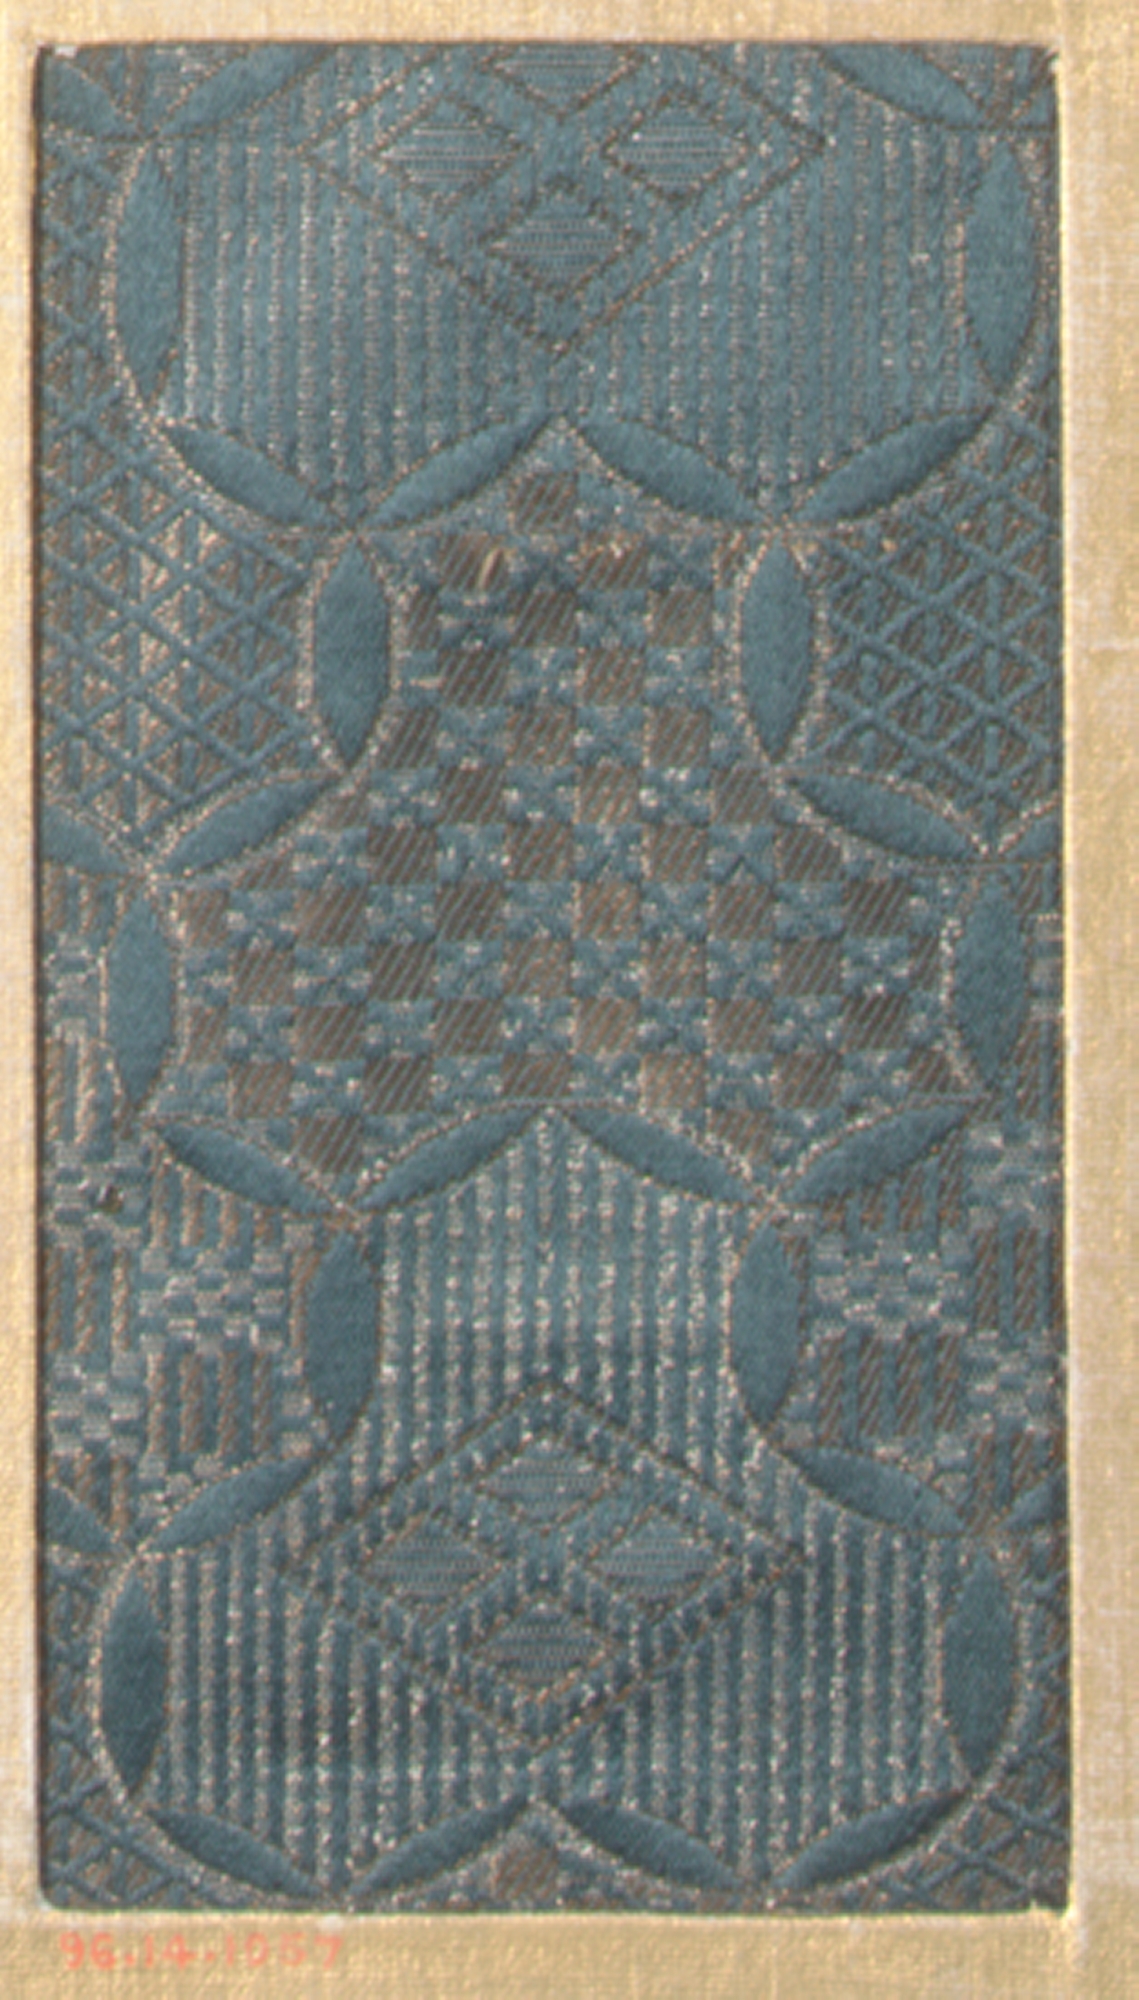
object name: piece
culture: japanese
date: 1701-1900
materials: silk